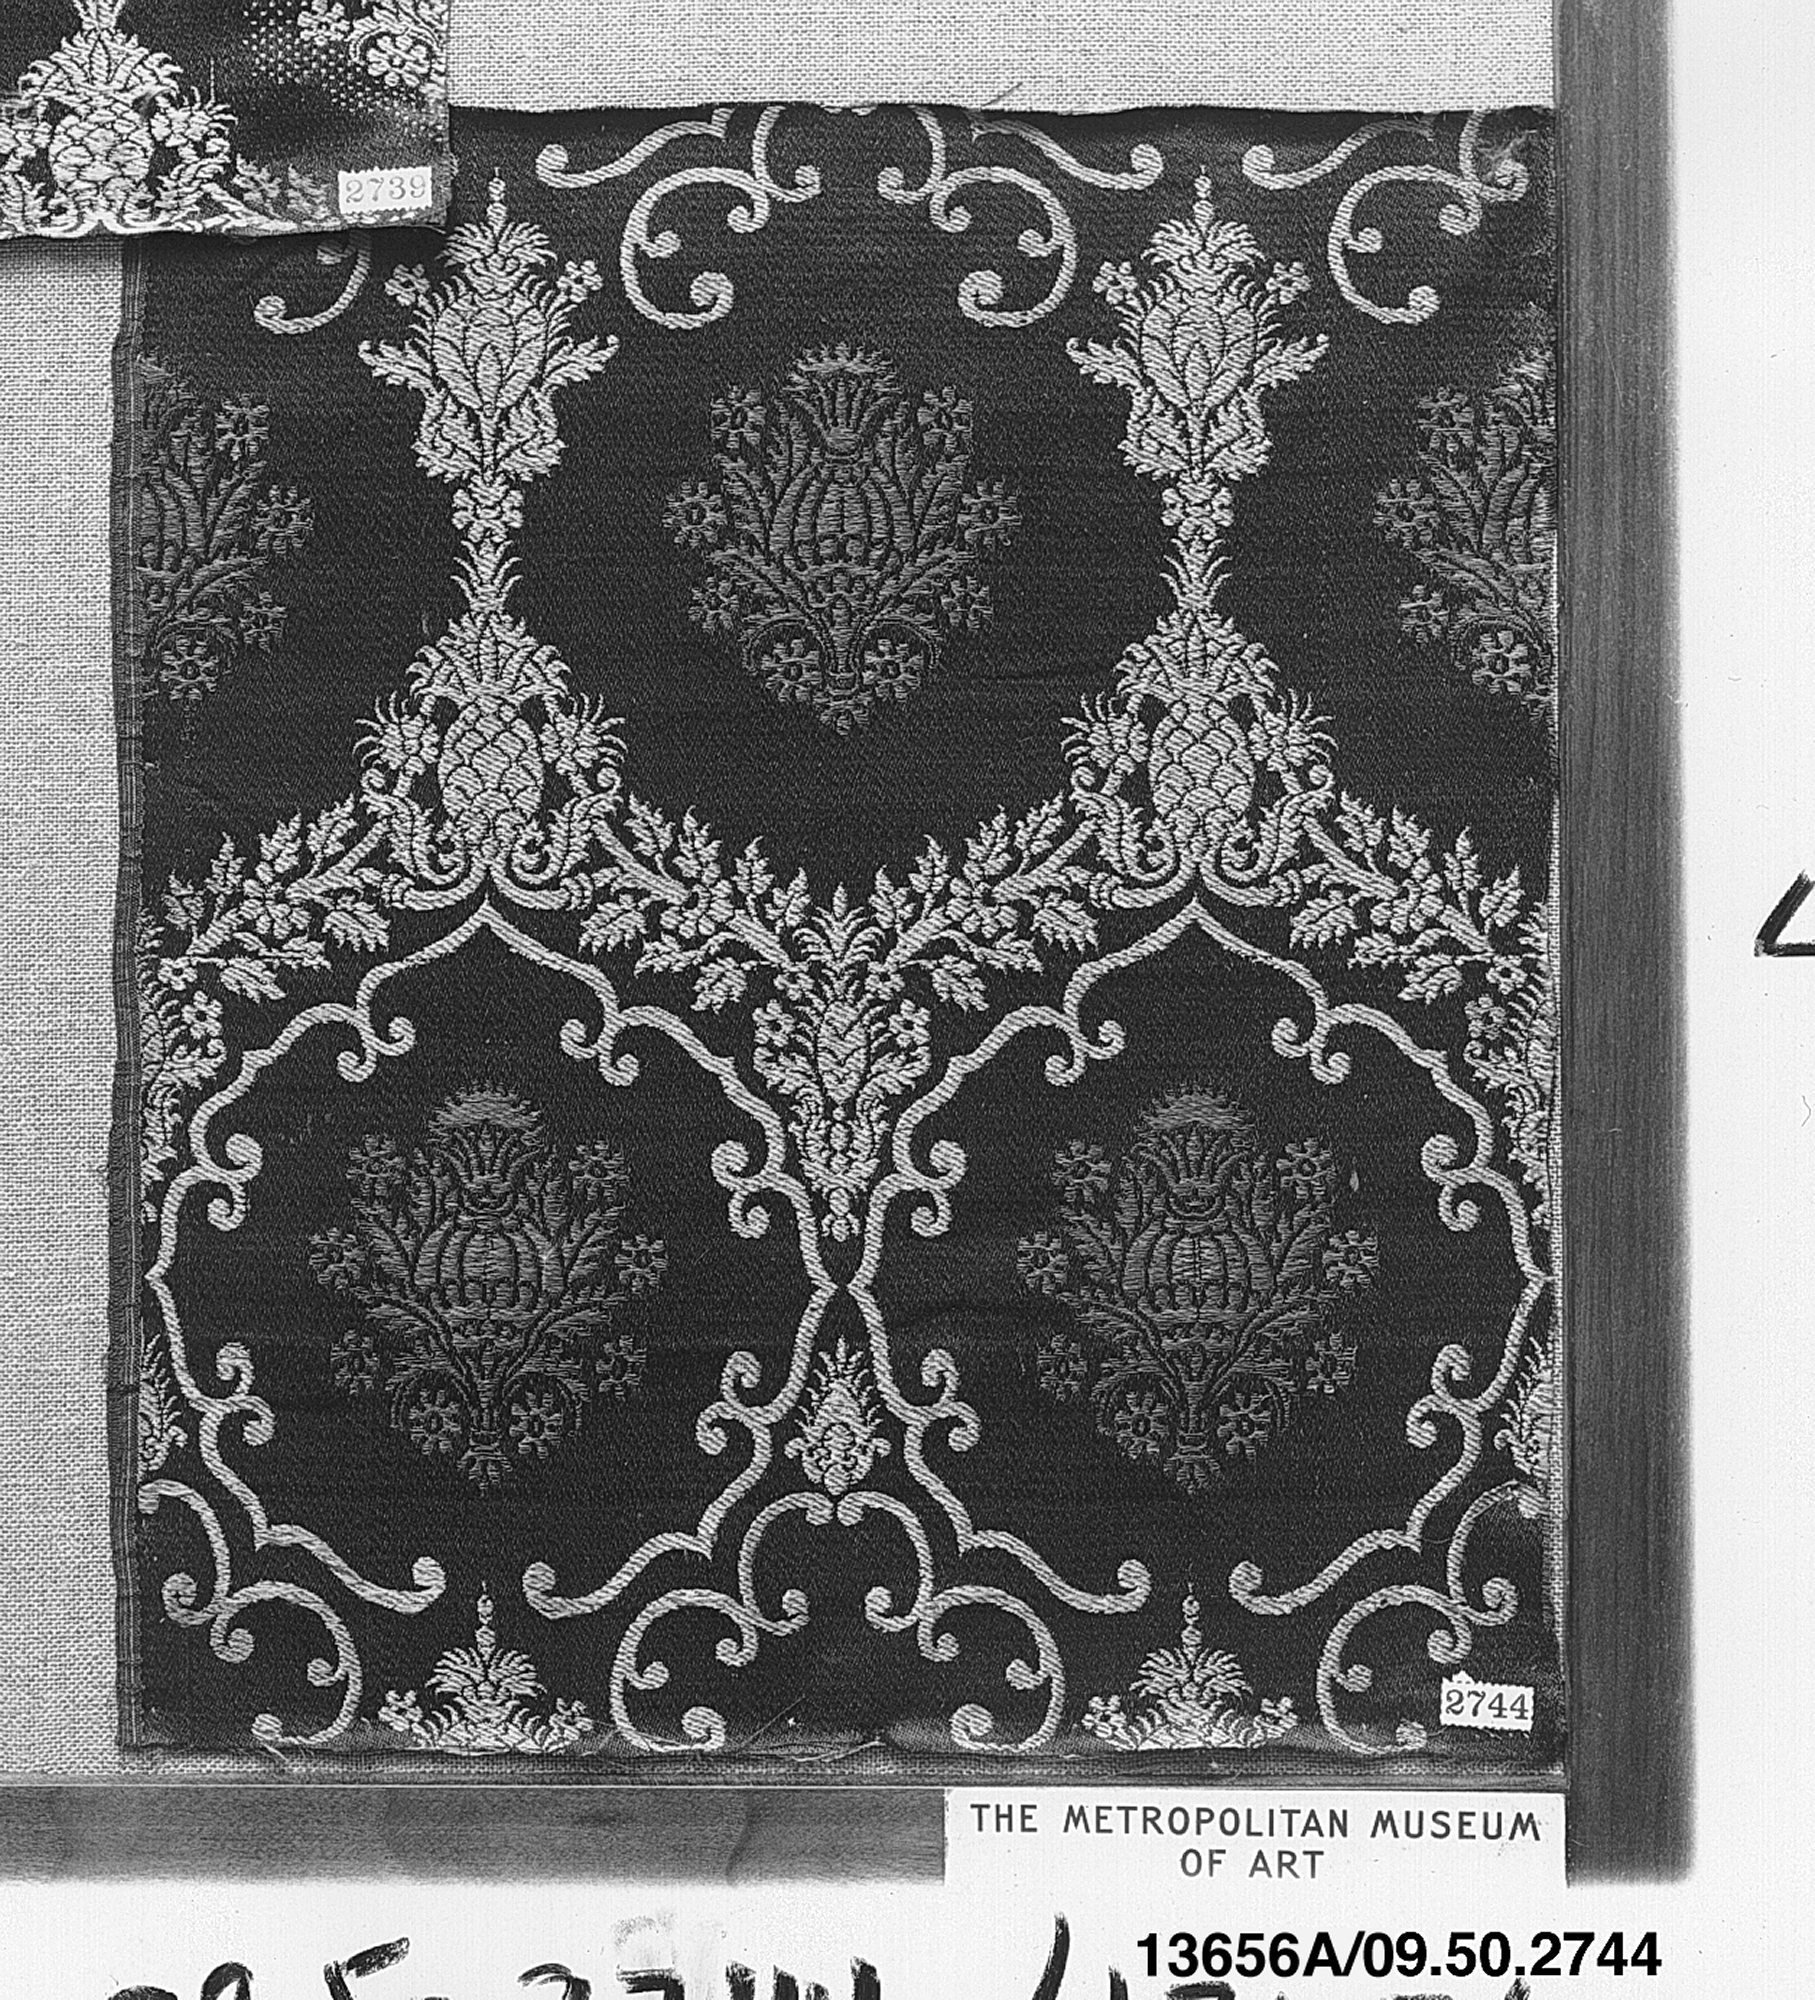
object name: piece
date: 1801-1900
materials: metal thread, silk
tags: flowers,leaves